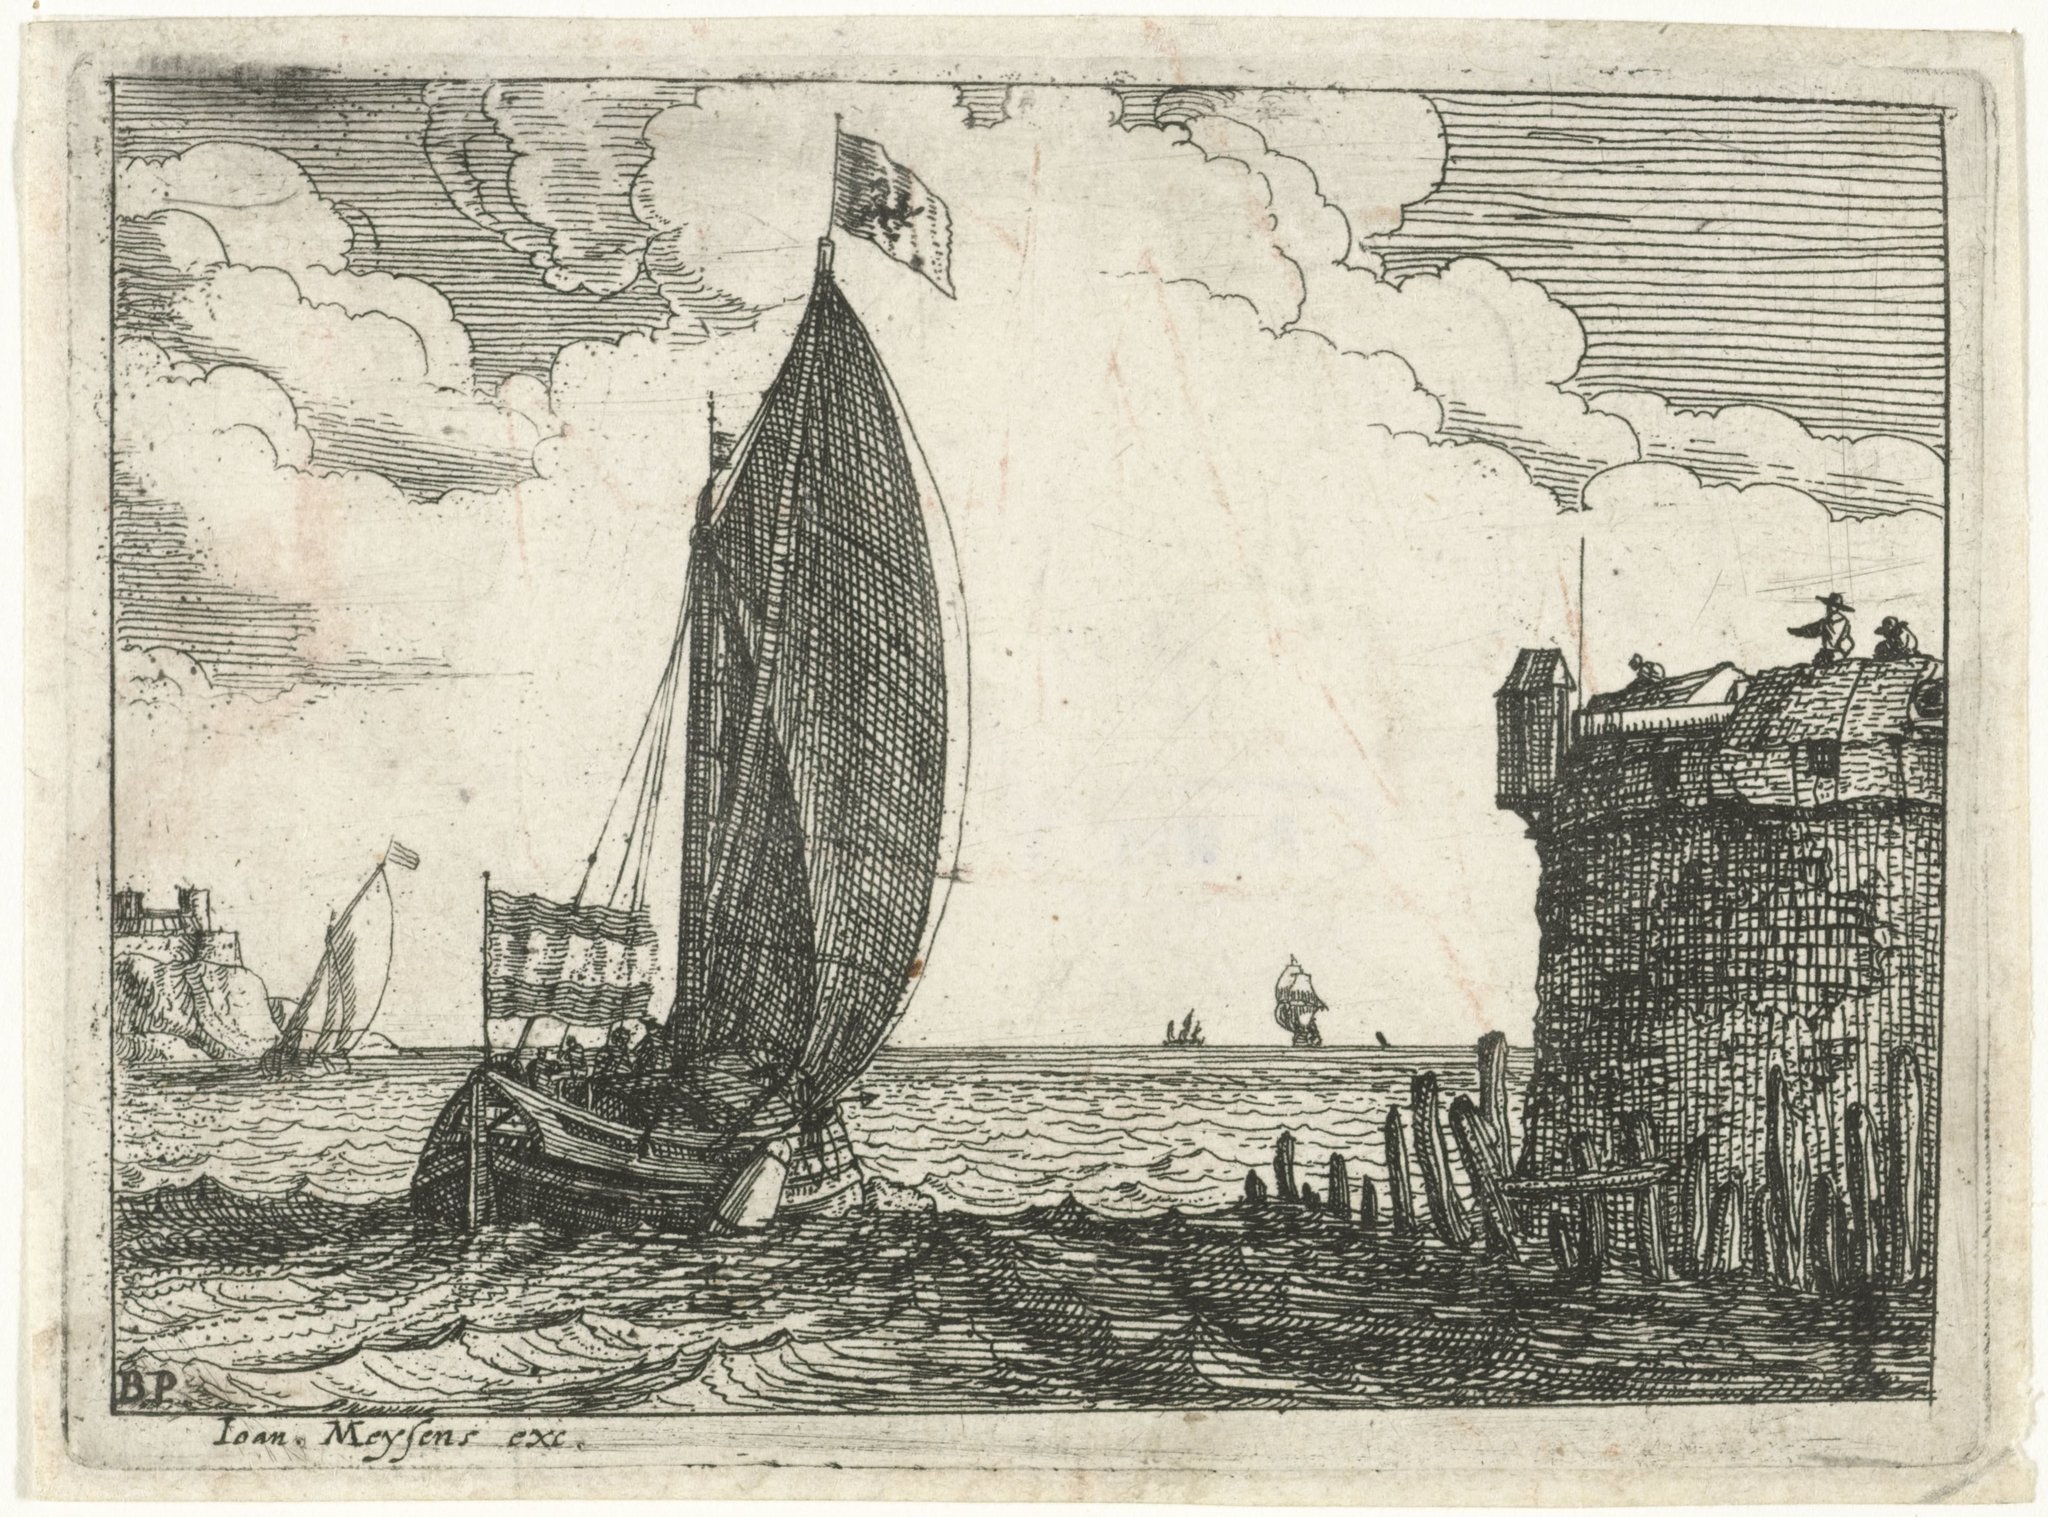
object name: print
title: Zeegezicht met rond bolwerk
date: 1624-1652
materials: paper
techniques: etching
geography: antwerp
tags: bastion, bulwark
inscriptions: collector's mark: Lugt 2228